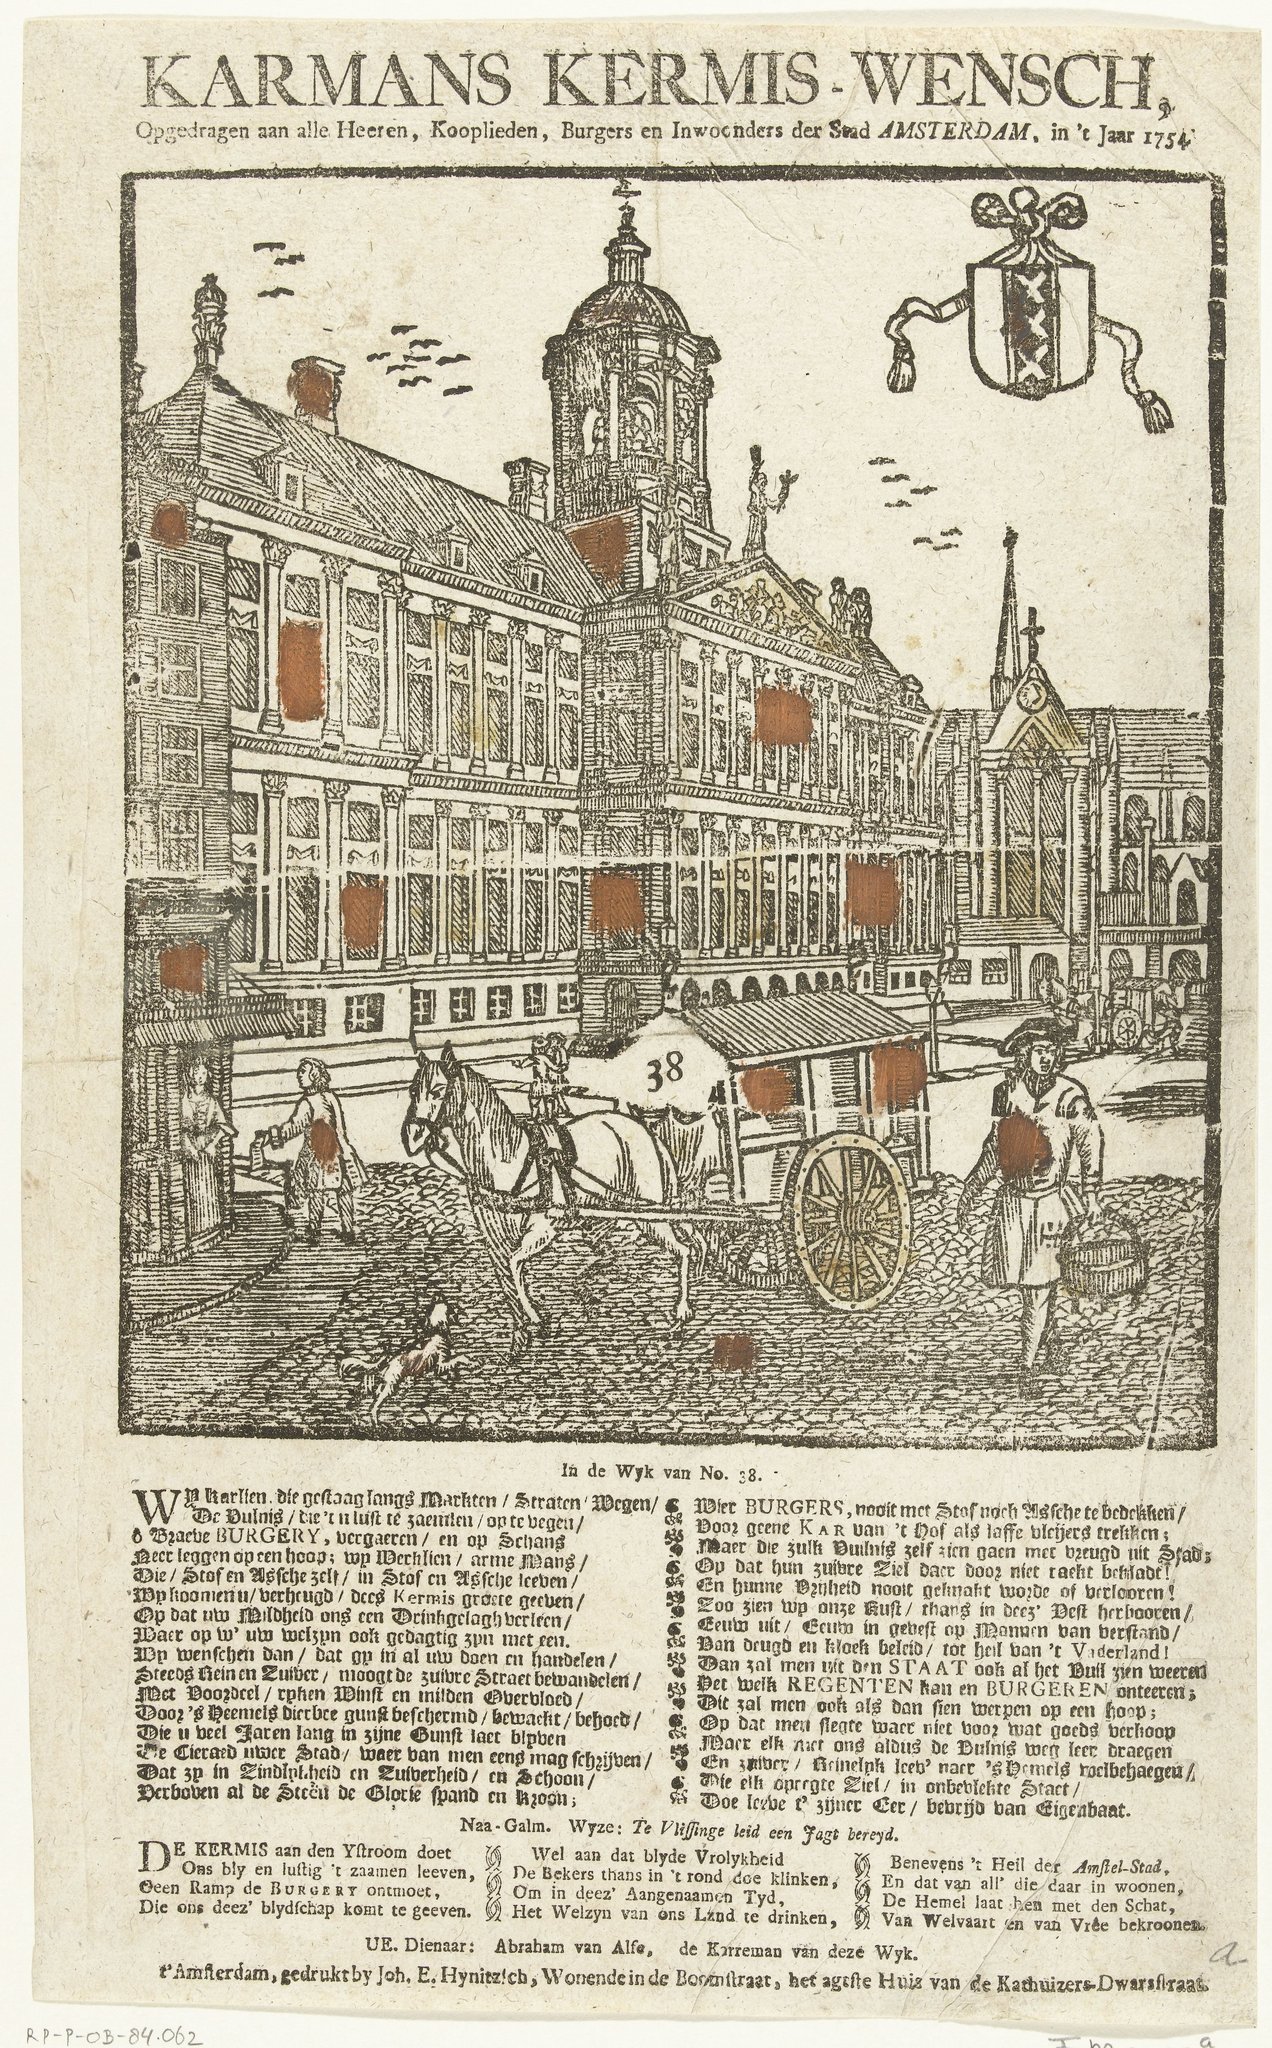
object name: print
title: Karmans Kermis-Wensch, Opgedragen aan alle Heeren, Kooplieden, Burgers en Inwoonders der Stad Amsterdam, in 't Jaar 1754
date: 1754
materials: paper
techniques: hand coloring, letterpress printing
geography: amsterdam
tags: garbage collecting lorry, garbage truck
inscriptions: collector's mark: Lugt 2228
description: Kermisprent voor het jaar 1754 van Abraham van Alse, de karrenman (askarrenman of vuilnisman) in de wijk 38, opgedragen aan de burgers van Amsterdam. Paard met askar gemerkt 38 op de Dam voor het Stadhuis. Op het blad onder de voorstelling een vers in twee kolommen met een lied in de nagalm in drie kolommen.